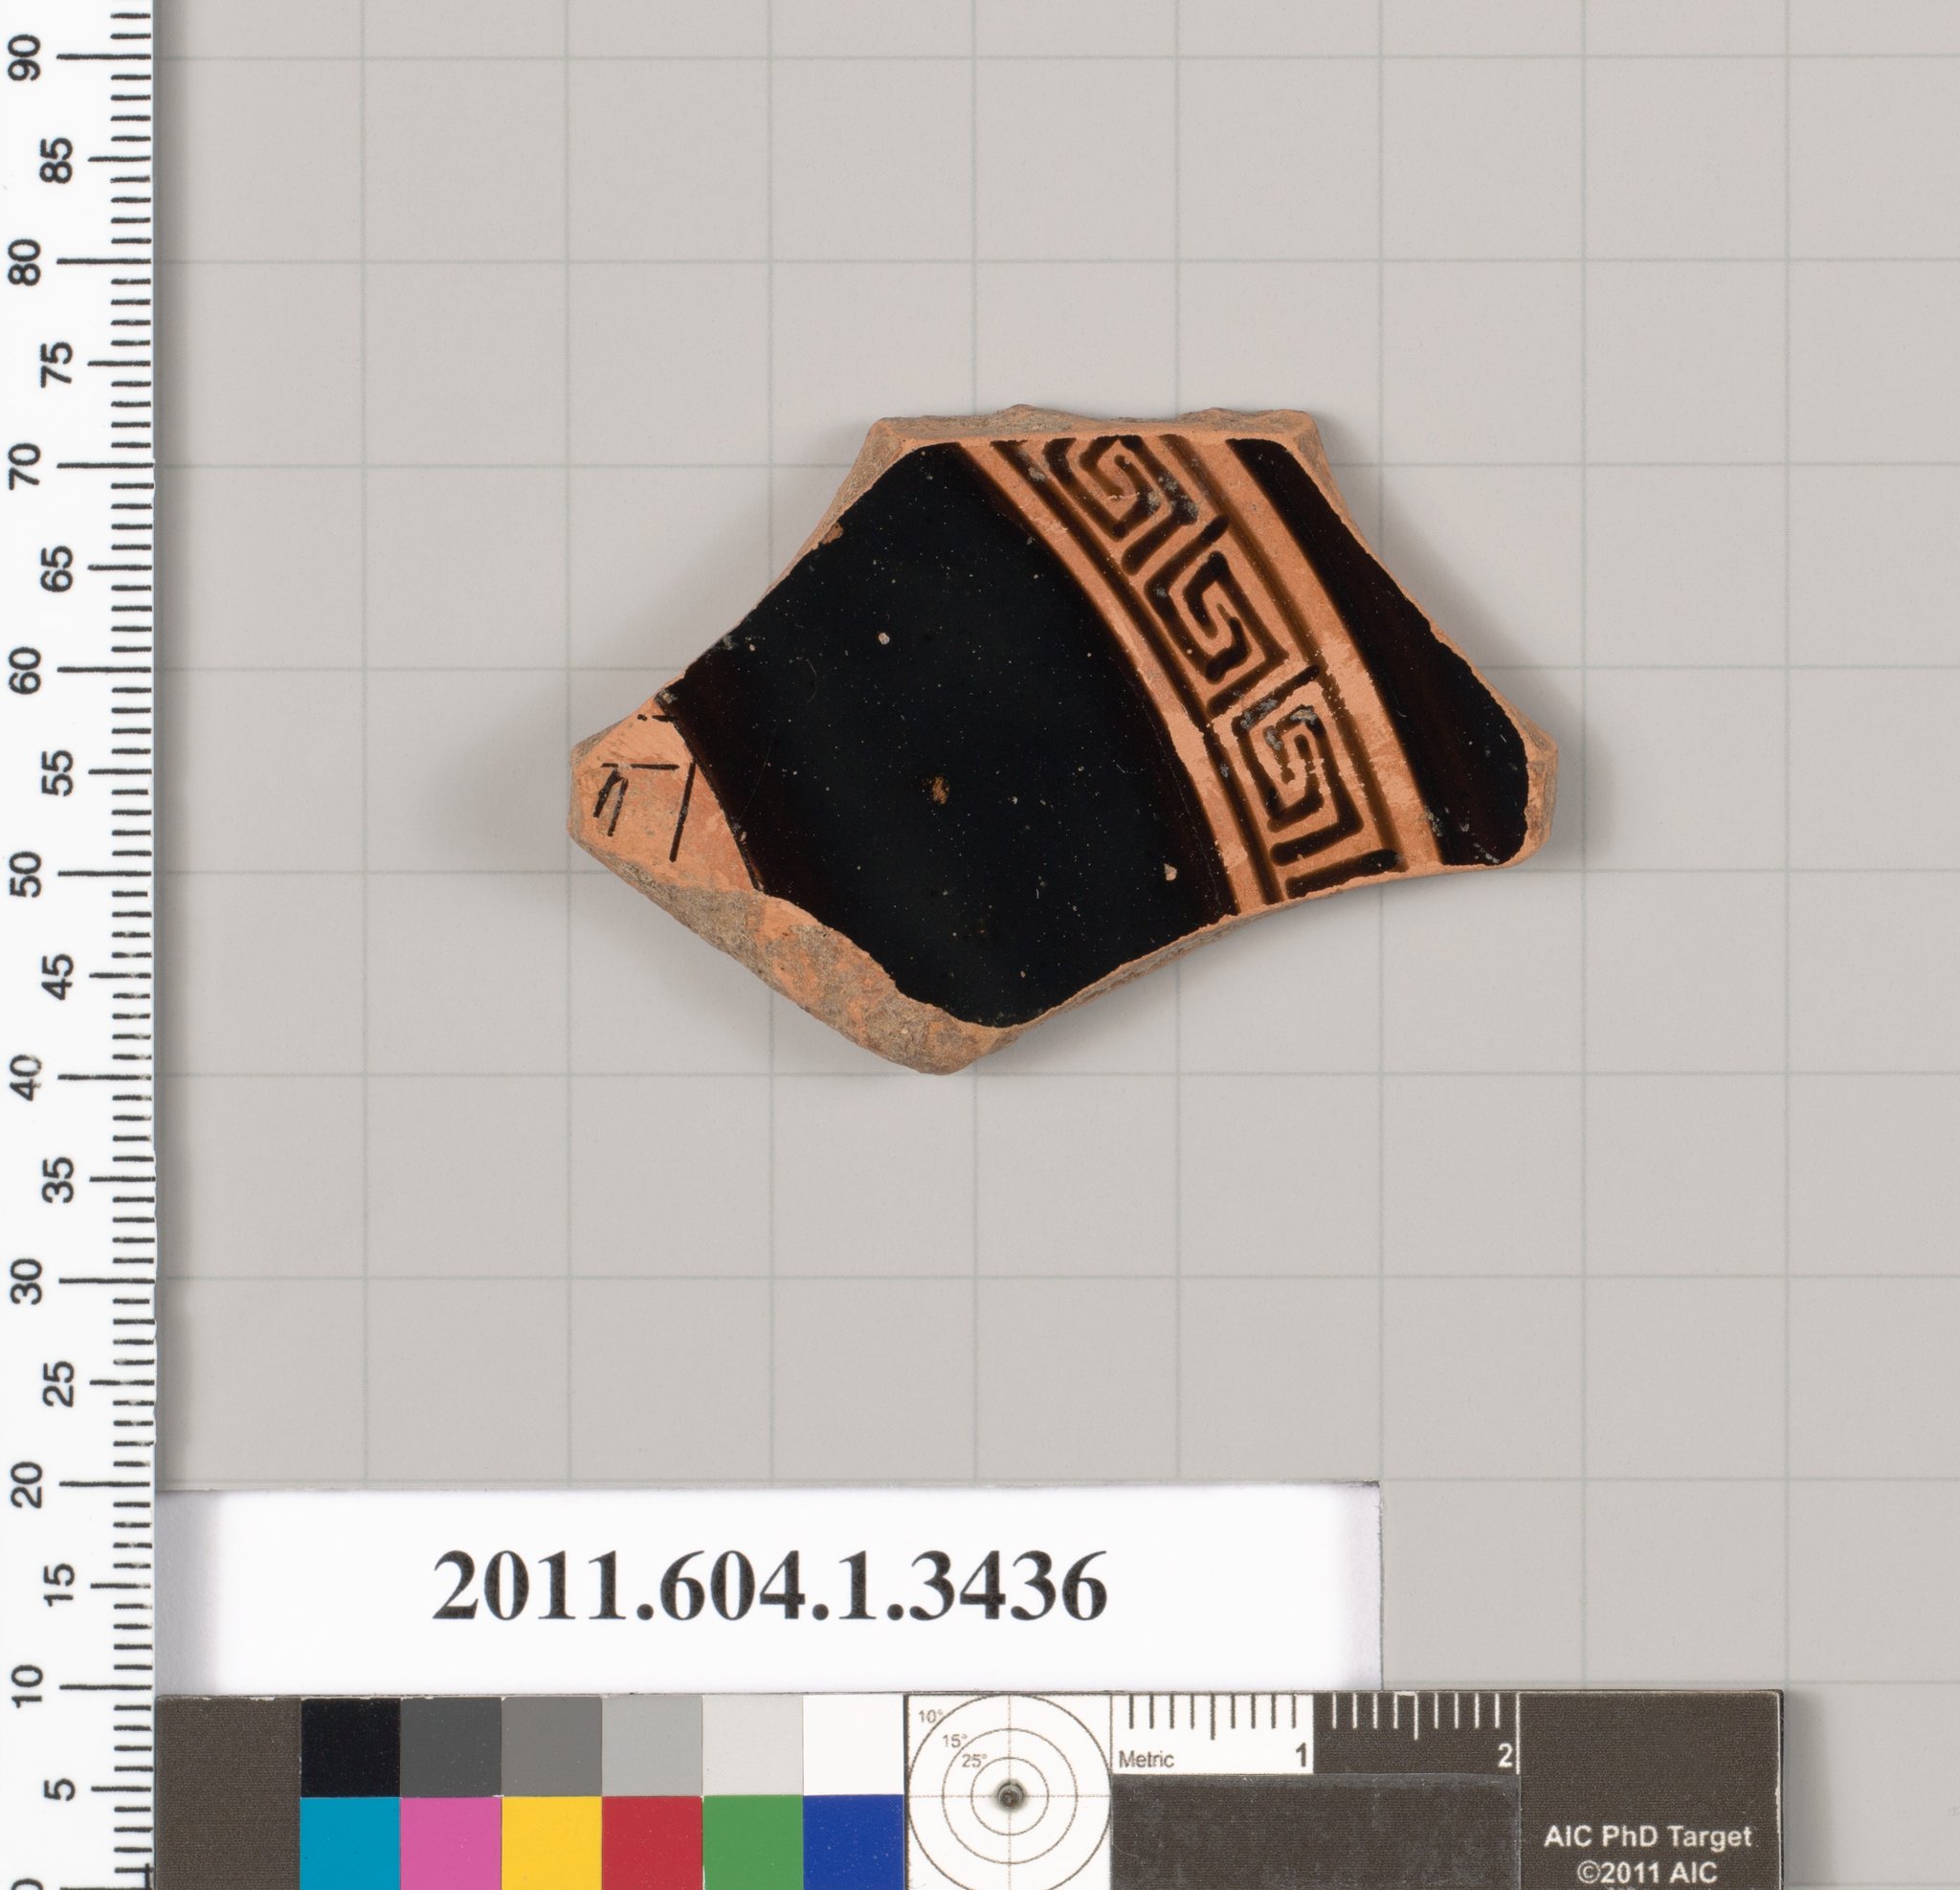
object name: kylix fragment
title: Terracotta fragment of a kylix (drinking cup)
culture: greek, attic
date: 490-470 BCE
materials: terracotta